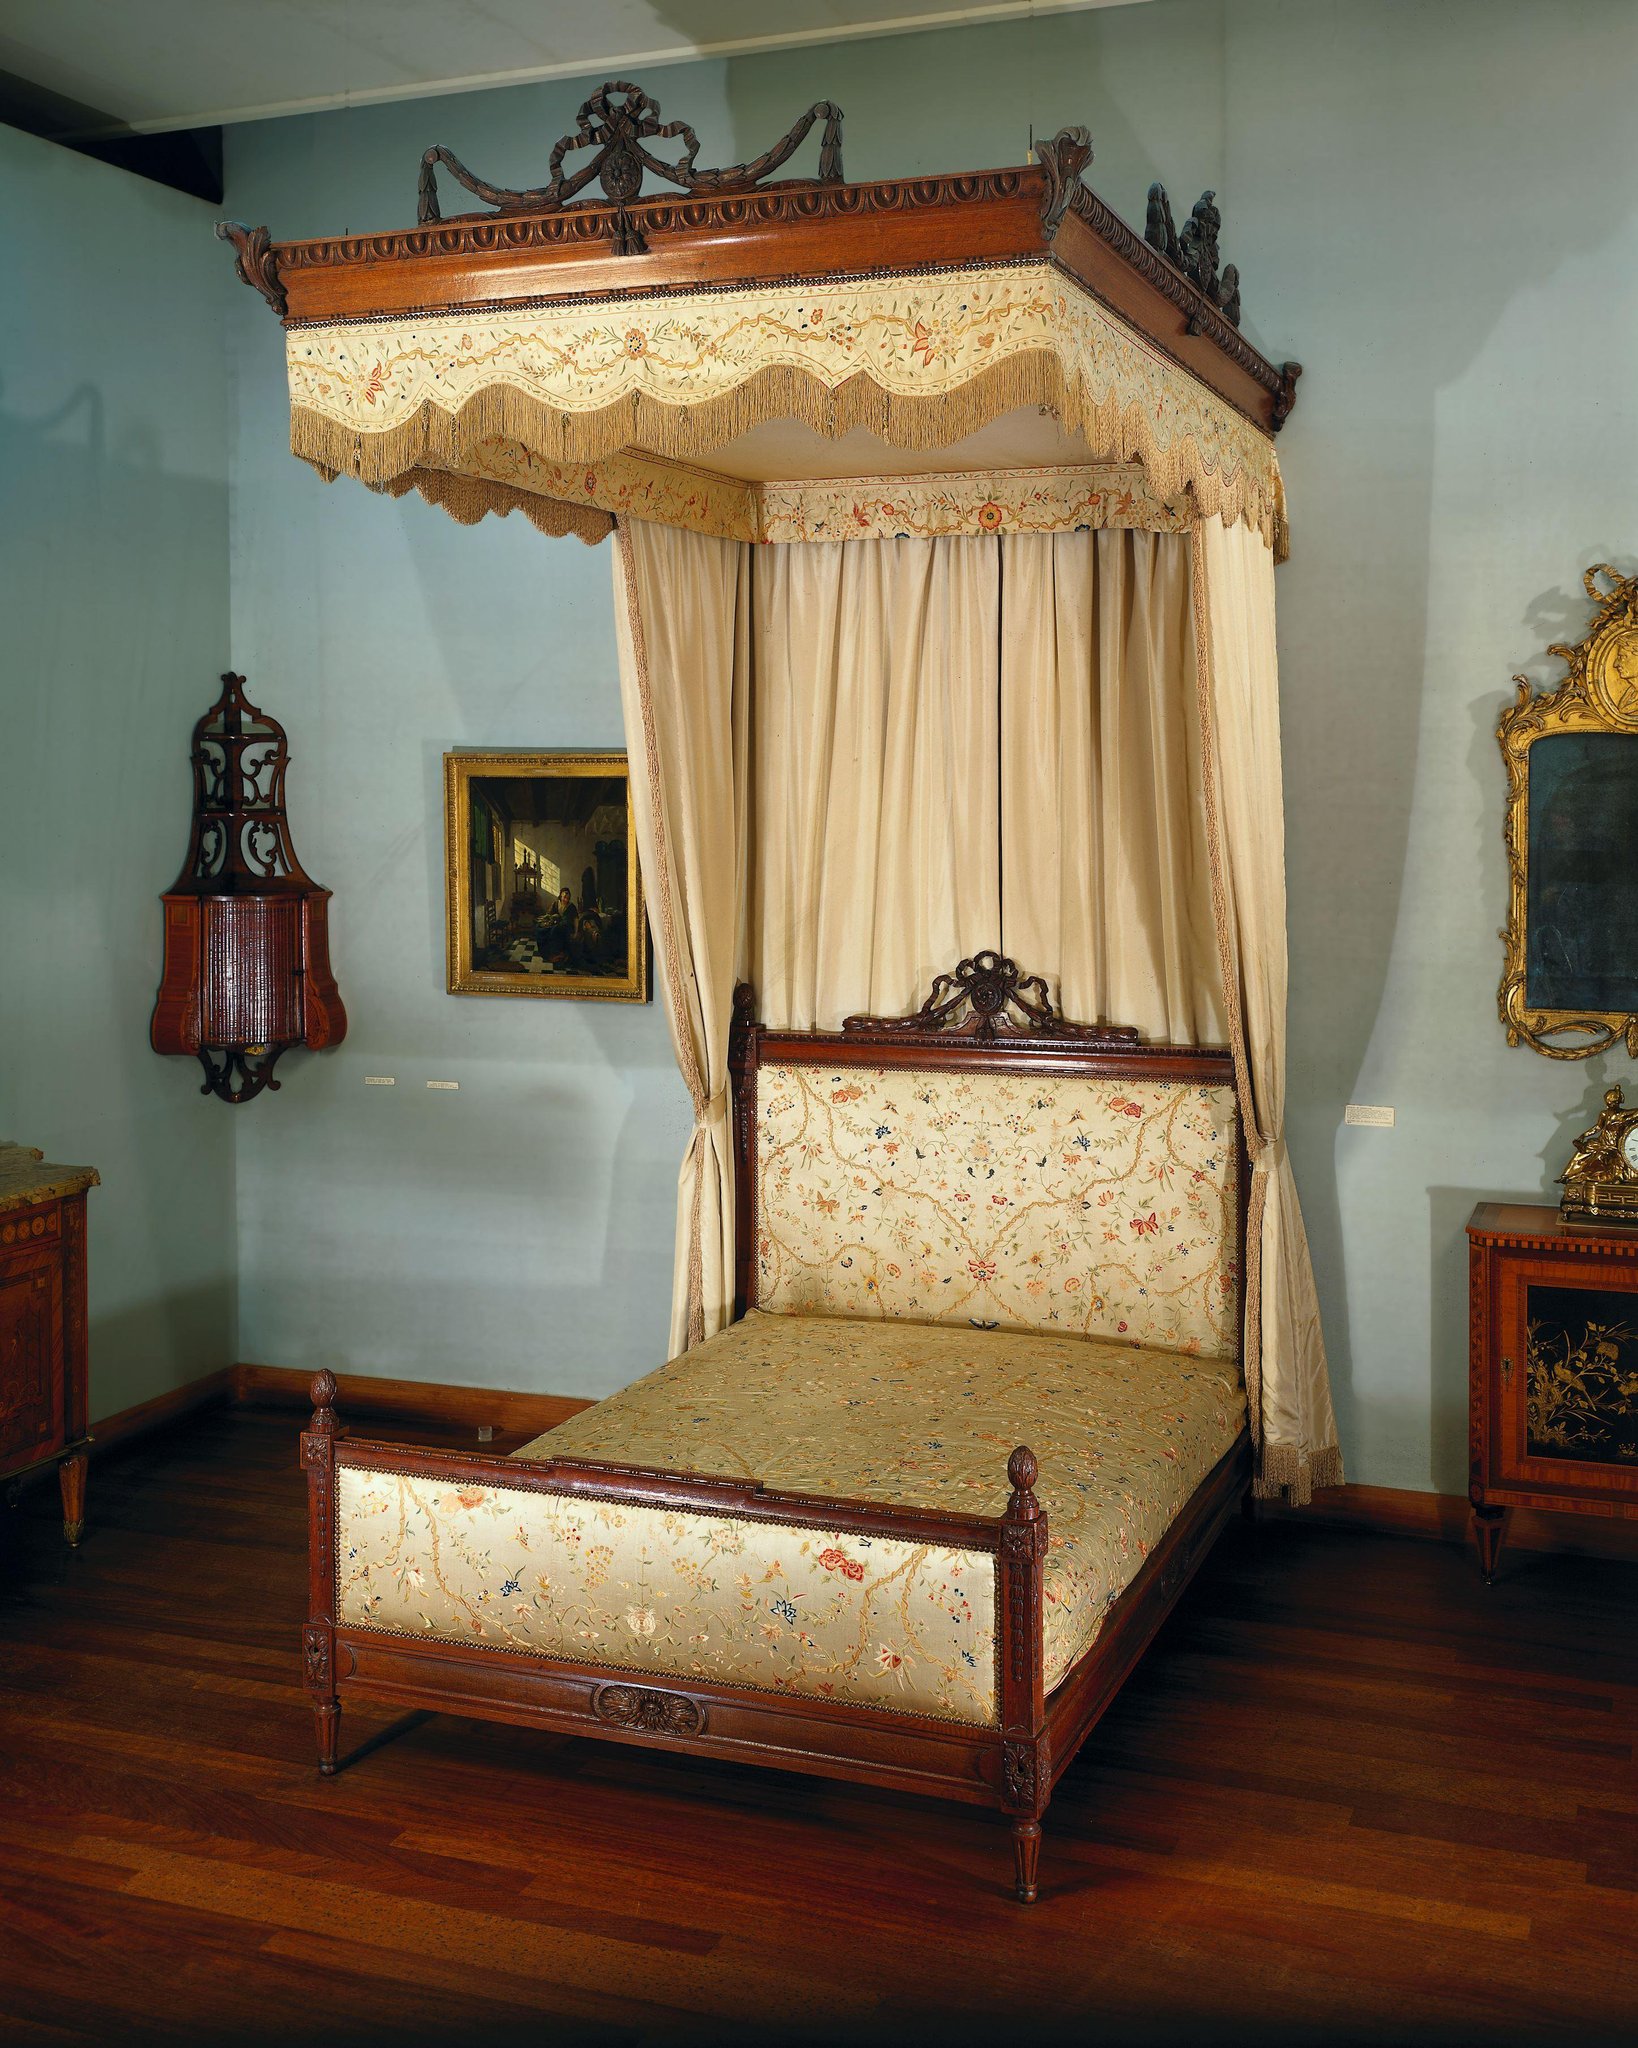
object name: textile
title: Strook, accoladevormig geschulpt, van crème-witte satijn, kleurig geborduurd met een rozet en slingerende rank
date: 1750-1800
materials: silk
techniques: embroidered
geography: china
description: Strook, accoladevormig geschulpt, van crème-witte satijn, kleurig geborduurd met een rozet en slingerende rank. Vormt een pendant met een tweede exemplaar. Chinese zijde.